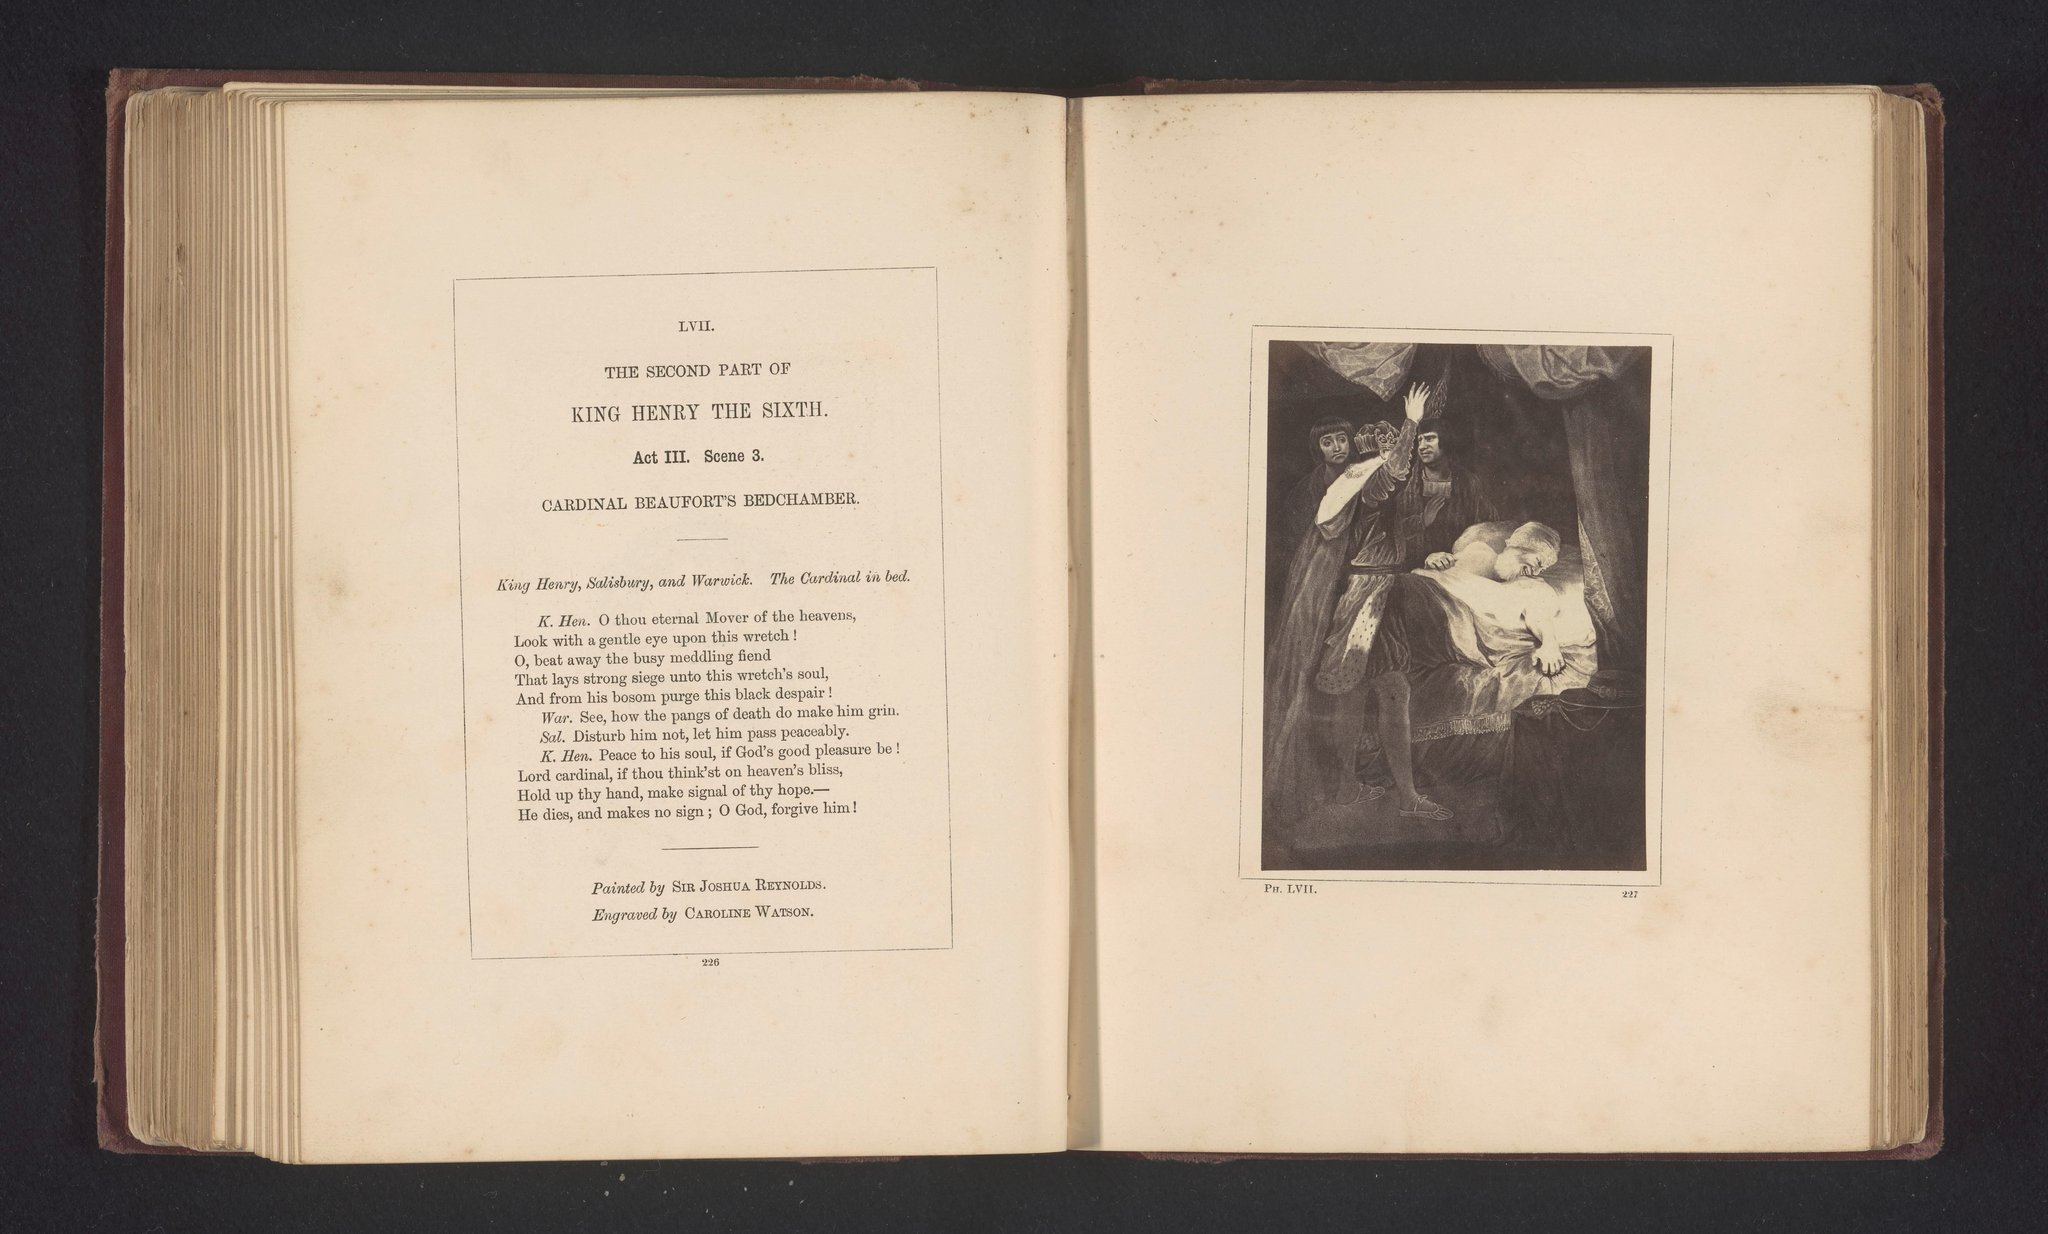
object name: photograph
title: Fotoreproductie van een prent naar een schilderij door Joshua Reynolds, voorstellend een scene uit Hendrik VI, deel 2 door William Shakespeare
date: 1854-1867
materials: photographic support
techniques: albumen print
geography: london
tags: london, specific works of literature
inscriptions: number: ‘Ph. LVII. 227’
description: Te zien is akte III, scene 3 met de kardinaal in bed en koning Henry VI, de graaf van Salisbury en de graaf van Warwick ervoor.